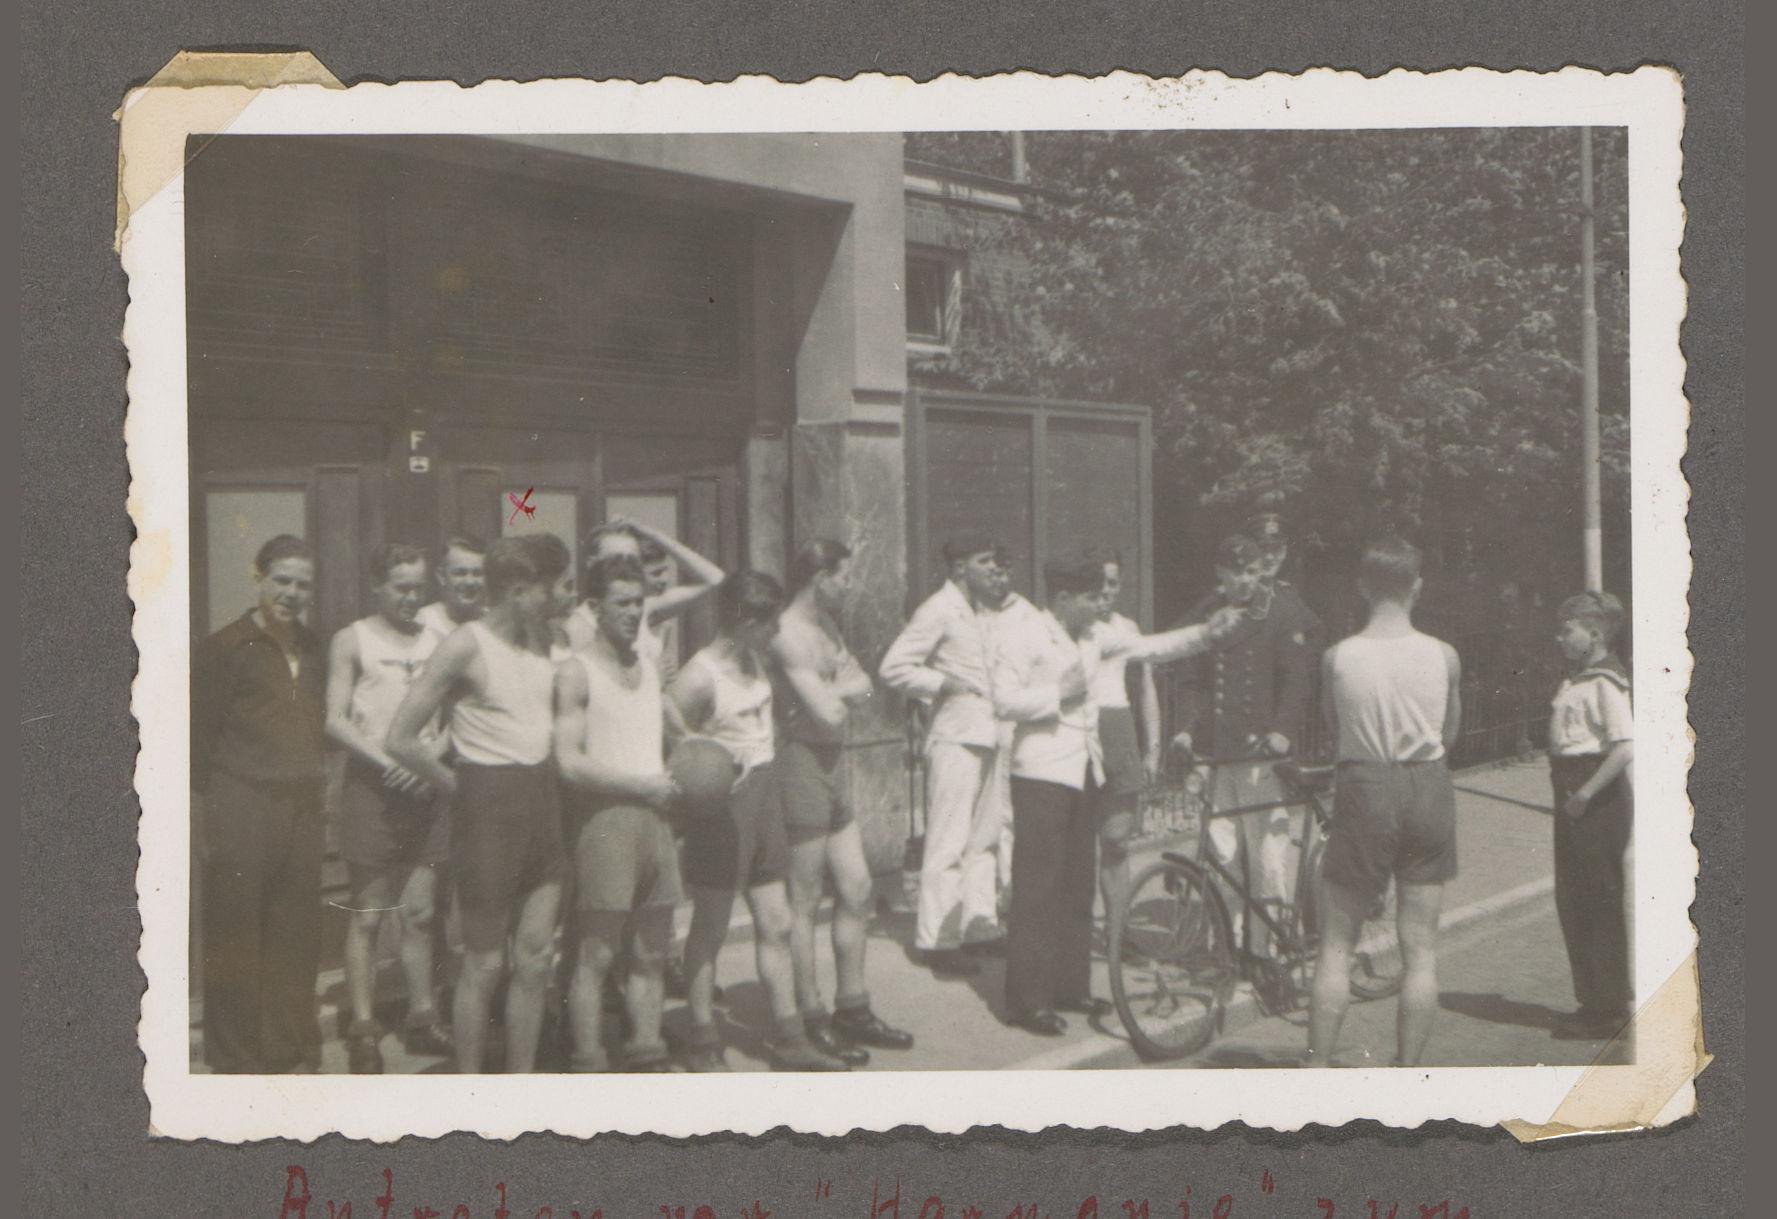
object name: photograph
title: Militairen, klaar om te voetballen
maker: Anonymous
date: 1941-1945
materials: paper, photographic support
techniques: gelatin silver print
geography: vlaardingen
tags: adult man, the soldier; the soldier's life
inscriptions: annotation: ‘Antreten vor "Harmonie"zum/ Fußballspiel’